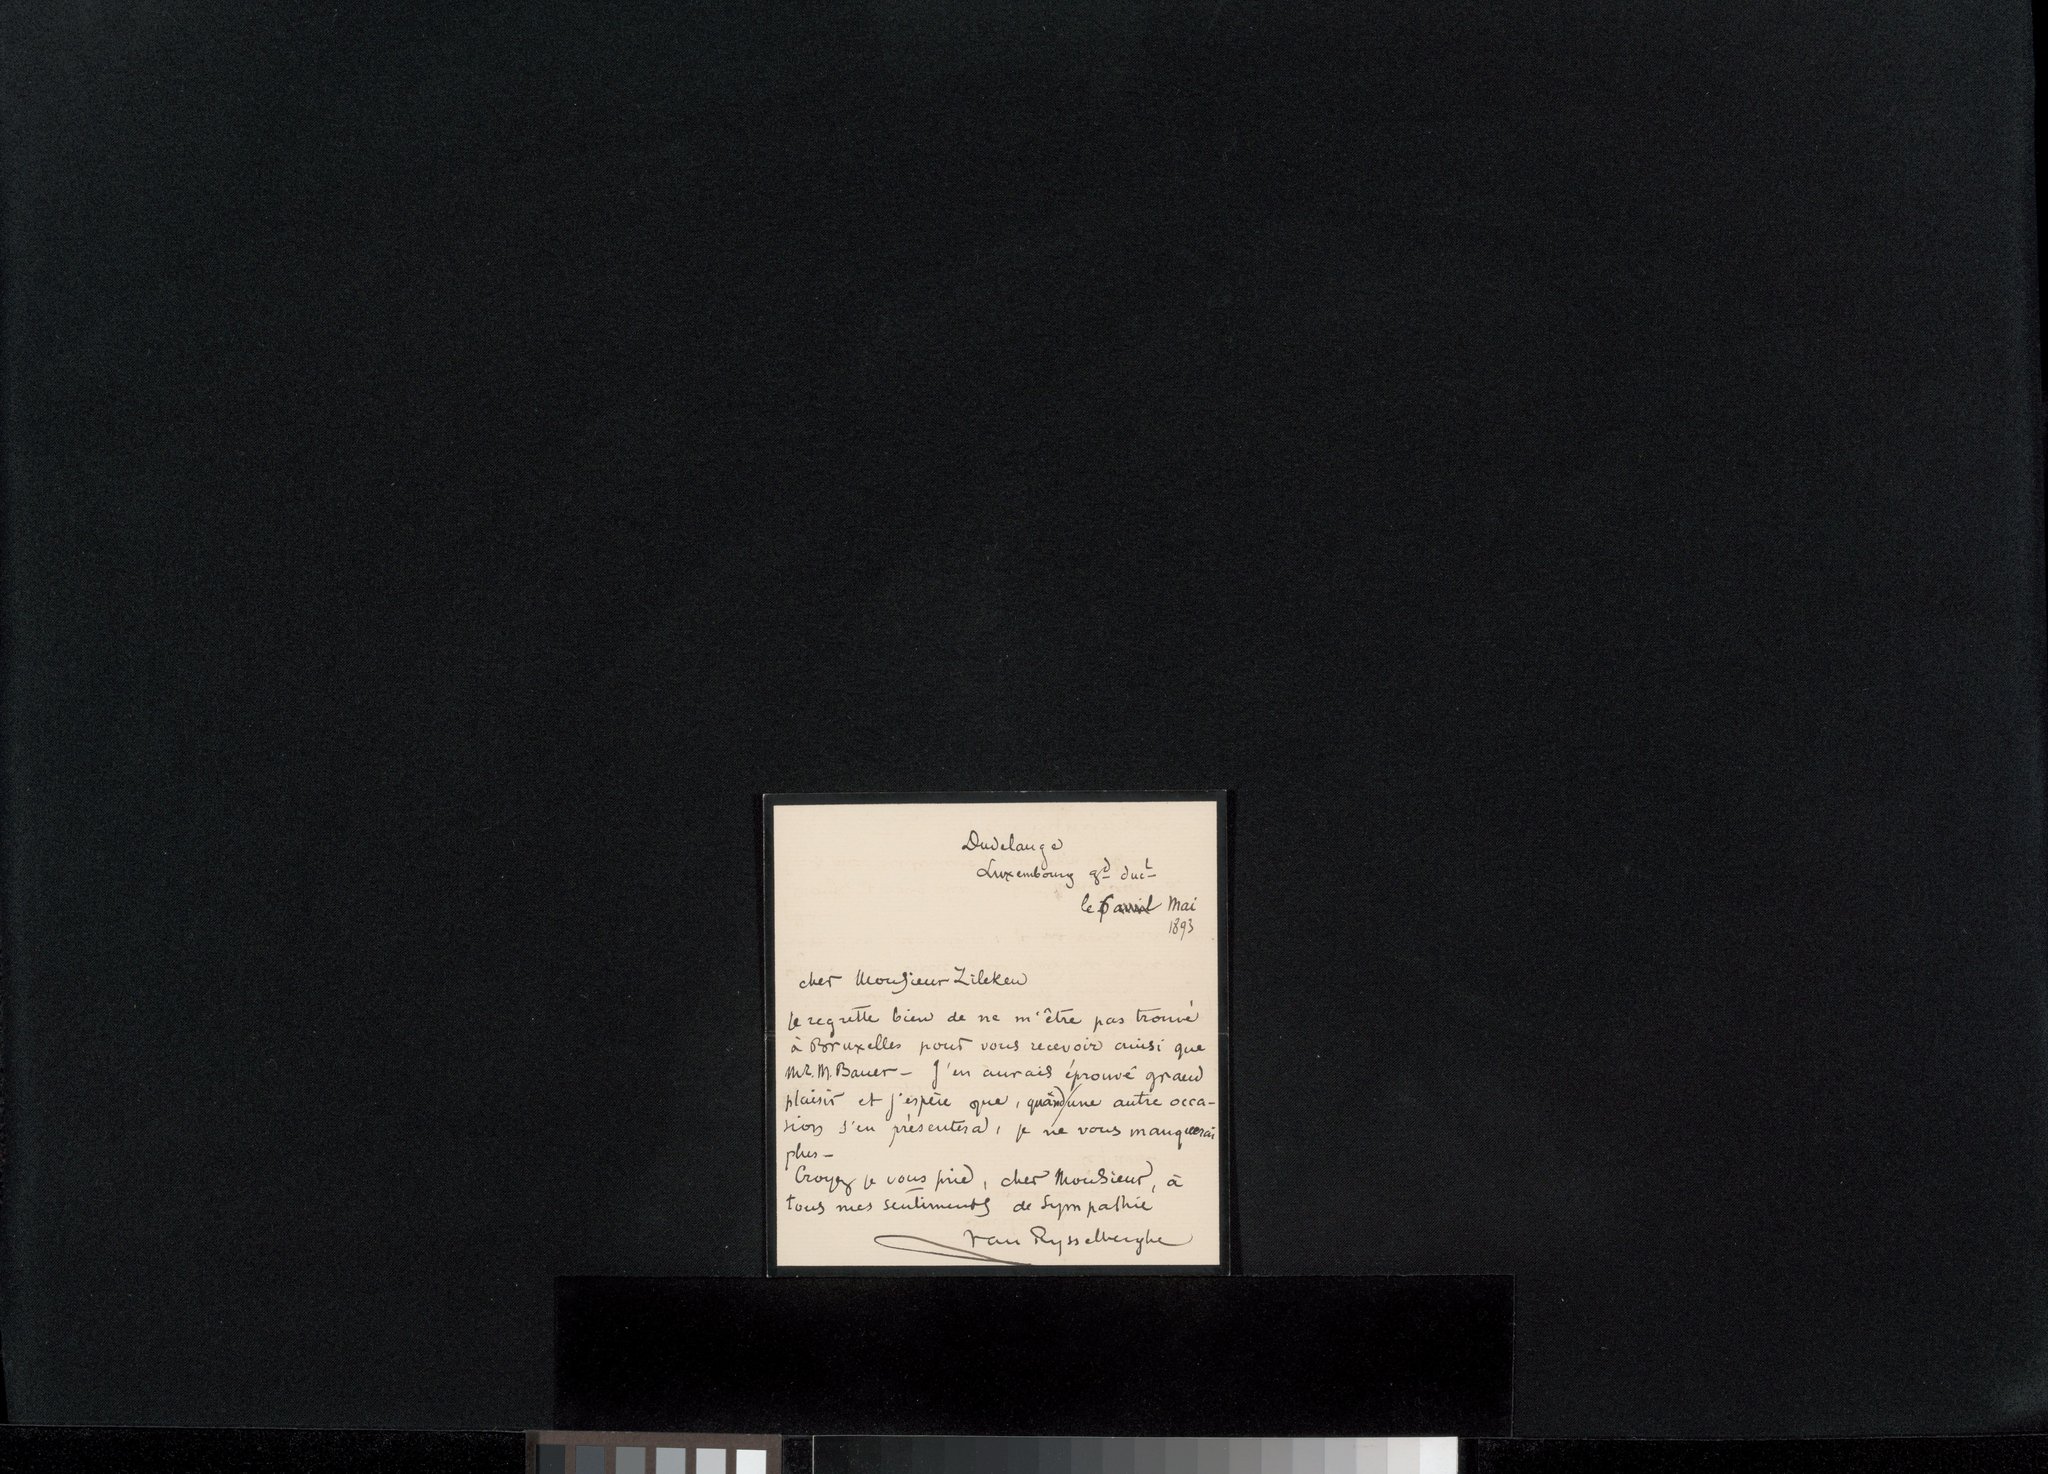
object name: letter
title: Brief aan Philip Zilcken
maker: theo van rysselberghe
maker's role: draughtsman, print maker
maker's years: 1862-1926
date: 1893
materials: ink, paper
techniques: pen, writing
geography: dudelange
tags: the hague, amsterdam, print maker, draughtsman, marius bauer, philip zilcken, brussels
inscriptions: collector's mark: ‘RPK’